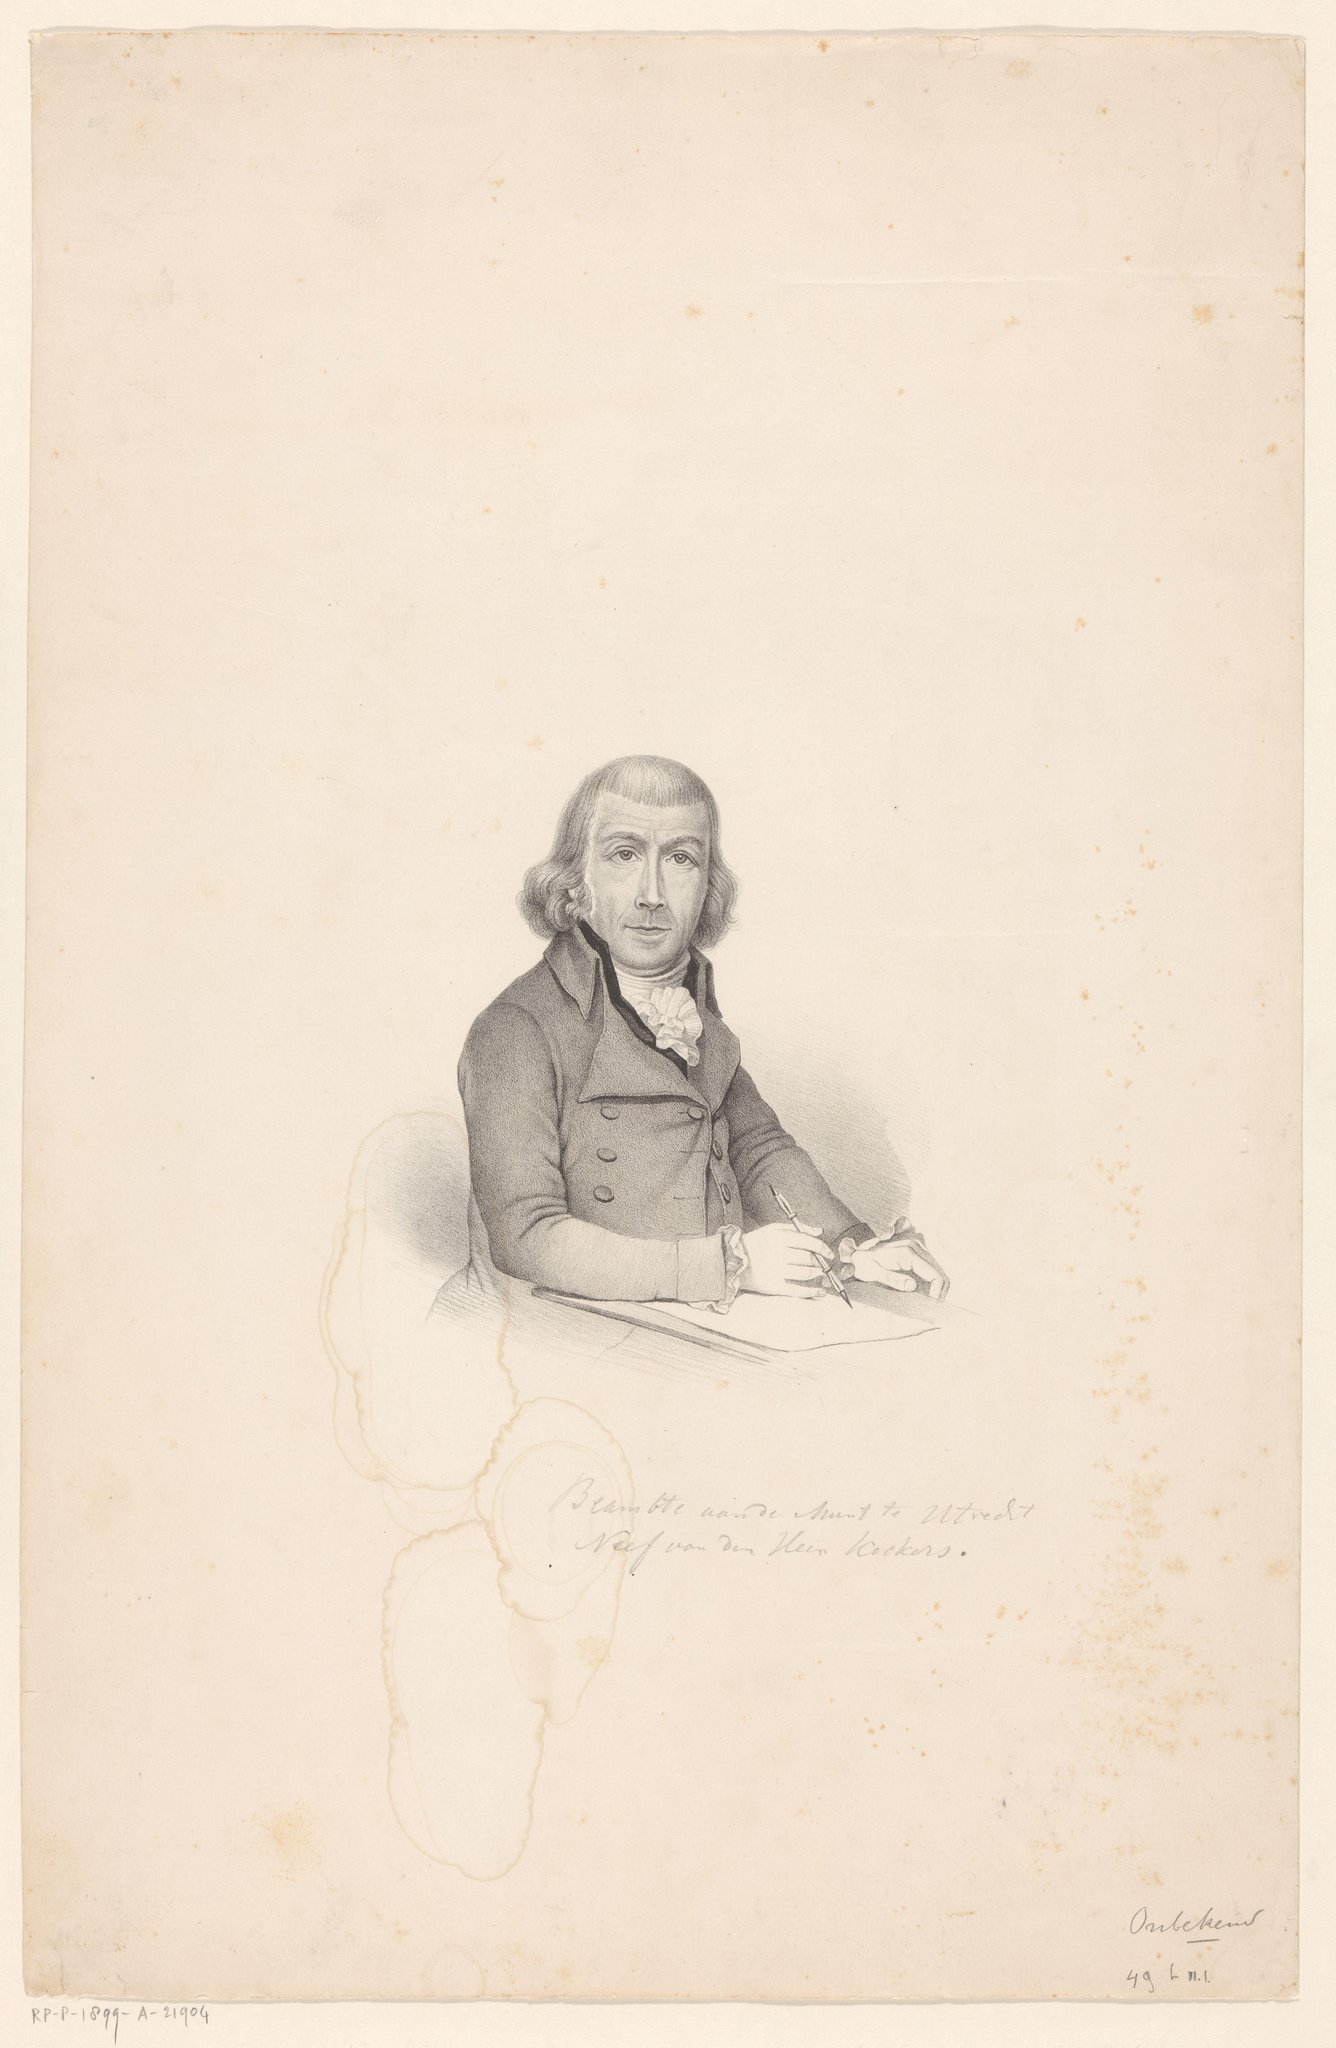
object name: print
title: Portret van een onbekende tekenende man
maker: Anonymous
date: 1800-1899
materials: paper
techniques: lithograph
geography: netherlands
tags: historical persons, secretary, scribe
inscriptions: inscription: ‘Beambte aan de munt te Utrecht/ Neef van den Heer Kockers.’, collector's mark: Lugt 2228